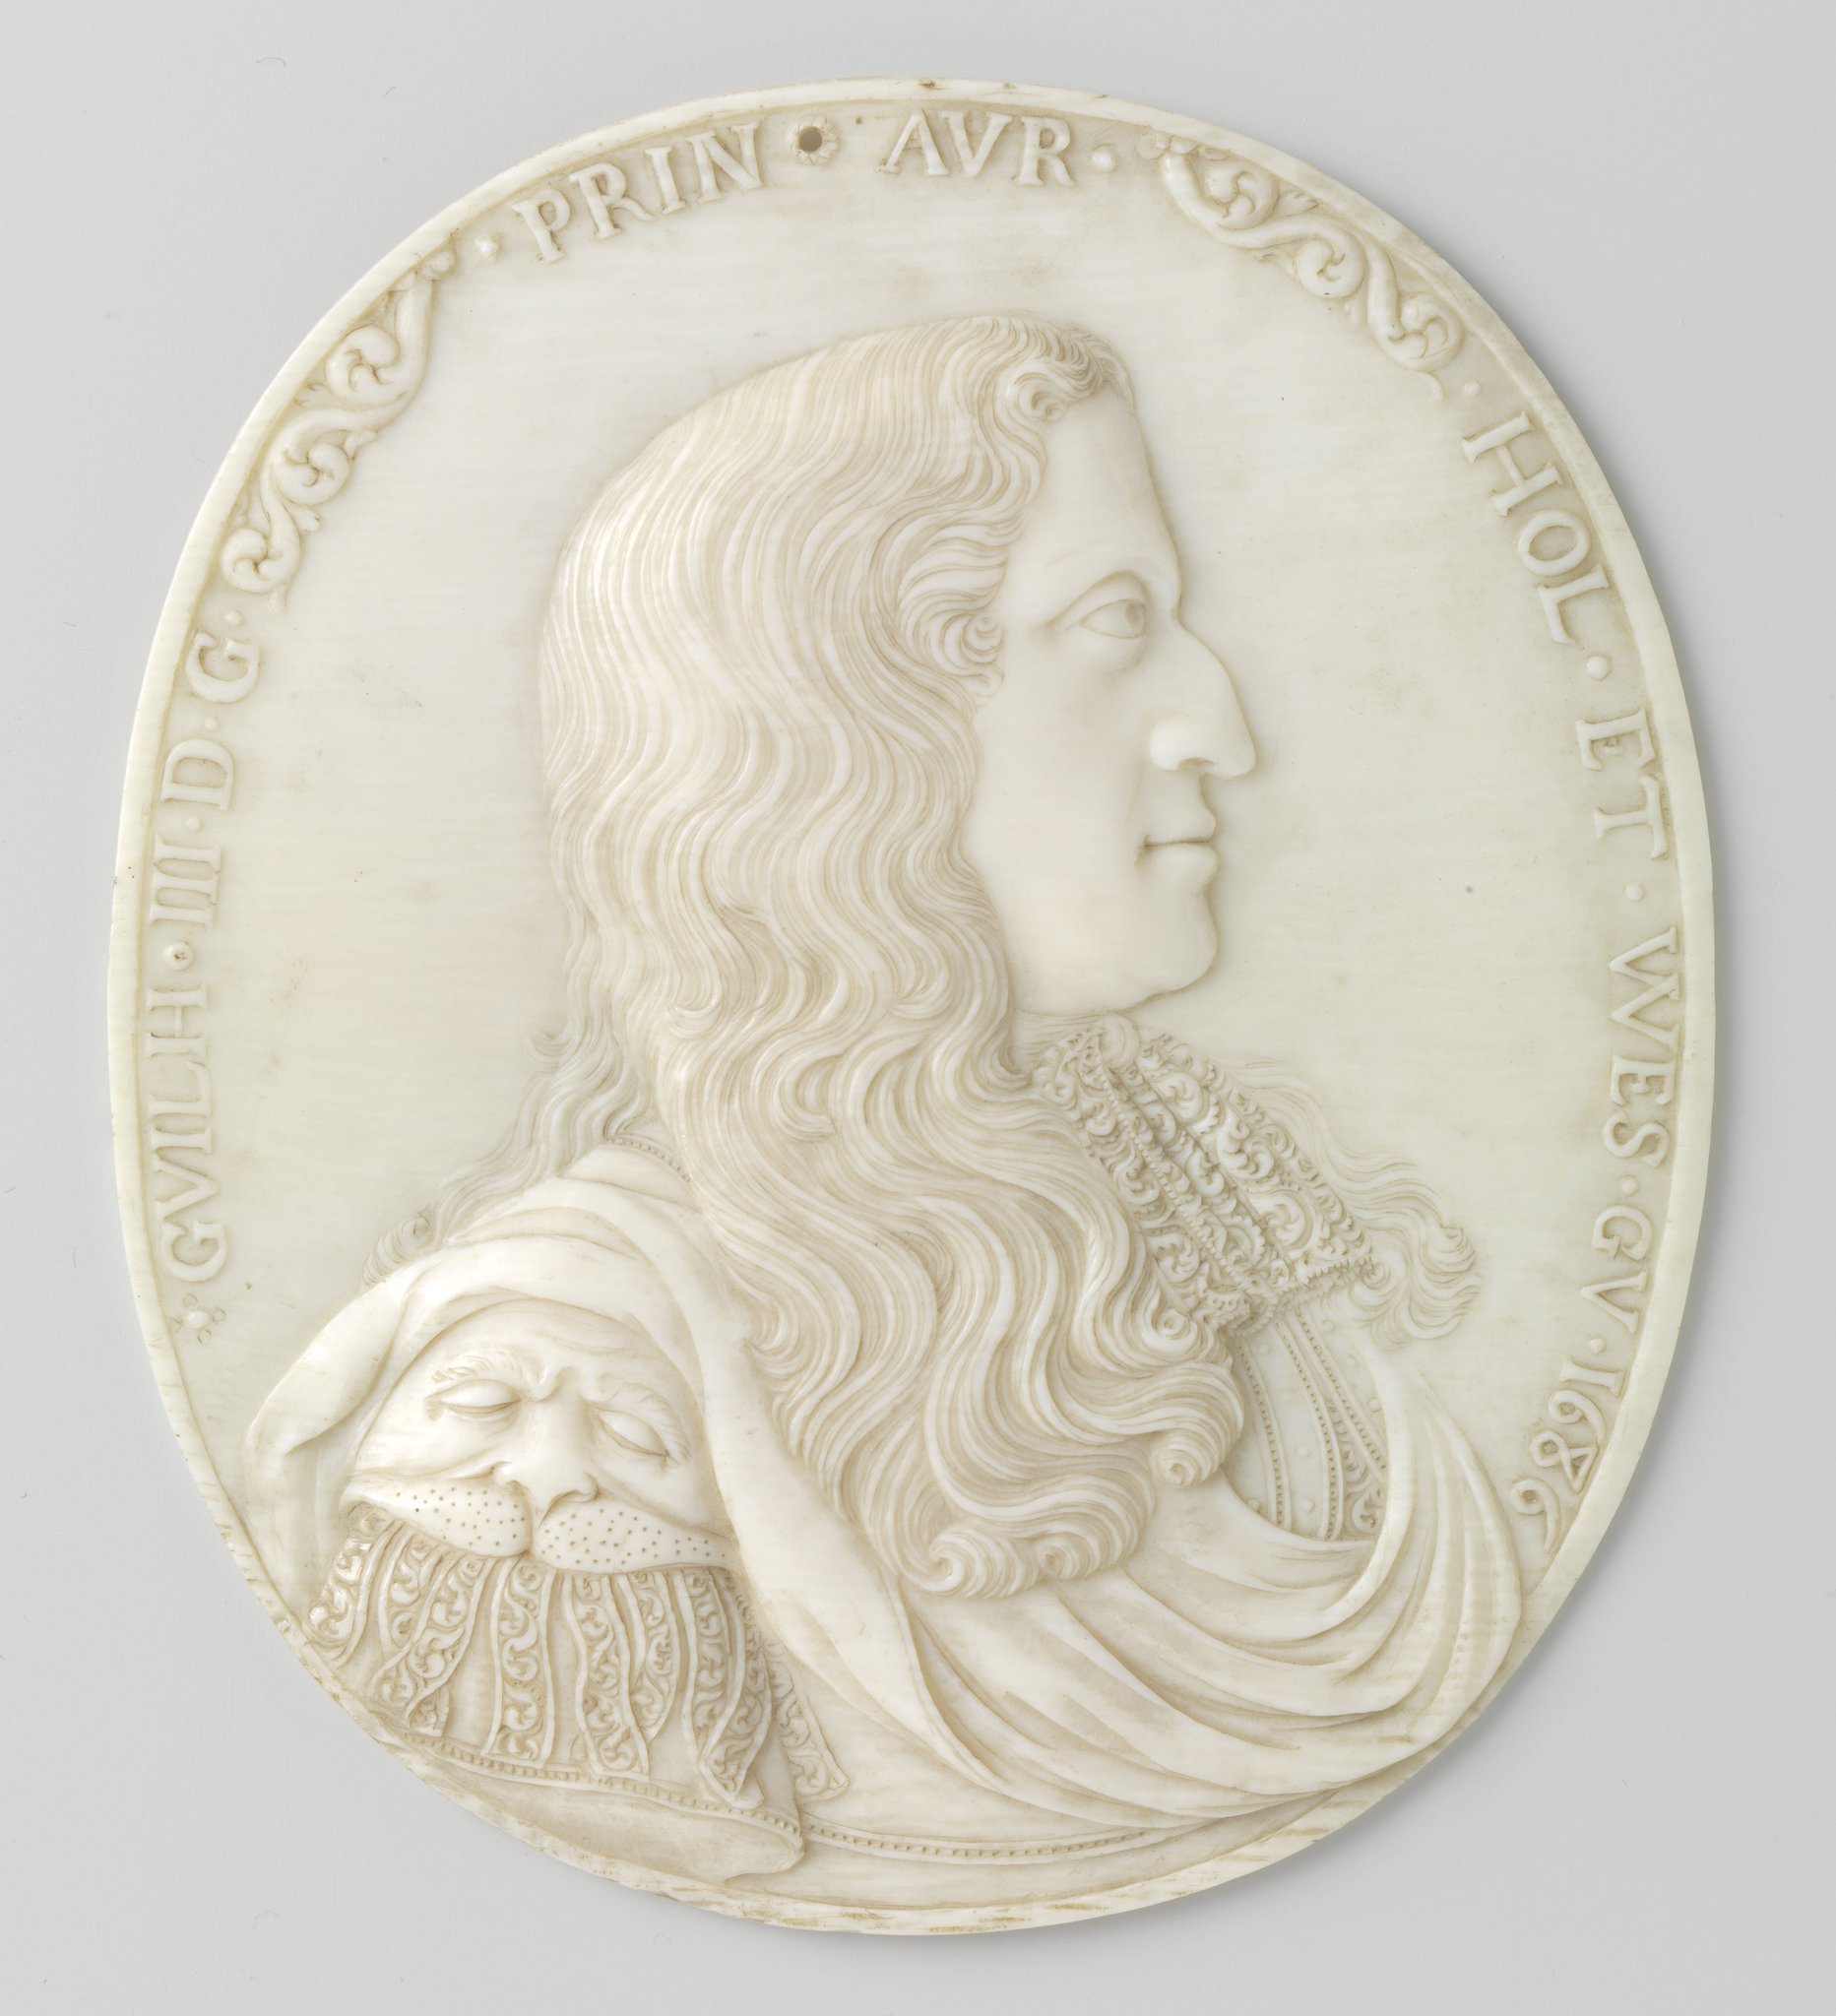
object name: sculpture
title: Medaillonportret van stadhouder Willem III (1650-1702)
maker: jean mansel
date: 1686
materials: ivory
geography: amsterdam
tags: the hague, william iii (prince of orange and king of england, scotland, and ireland)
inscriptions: inscription, on the reverse, in pencil: ‘K.O.G F. 17’, inscription and date, along the edge, in raised relief: ‘GVILH·III·D·G·PRIN·AVR·HOL·ET·WES·GV·1686’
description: Orange souvenirs. William III's popularity, and later also that of his wife Mary, gave rise to a wide variety of objects sporting their pictures: medallions, glasses, tiles, cutlery and Delftware pottery.